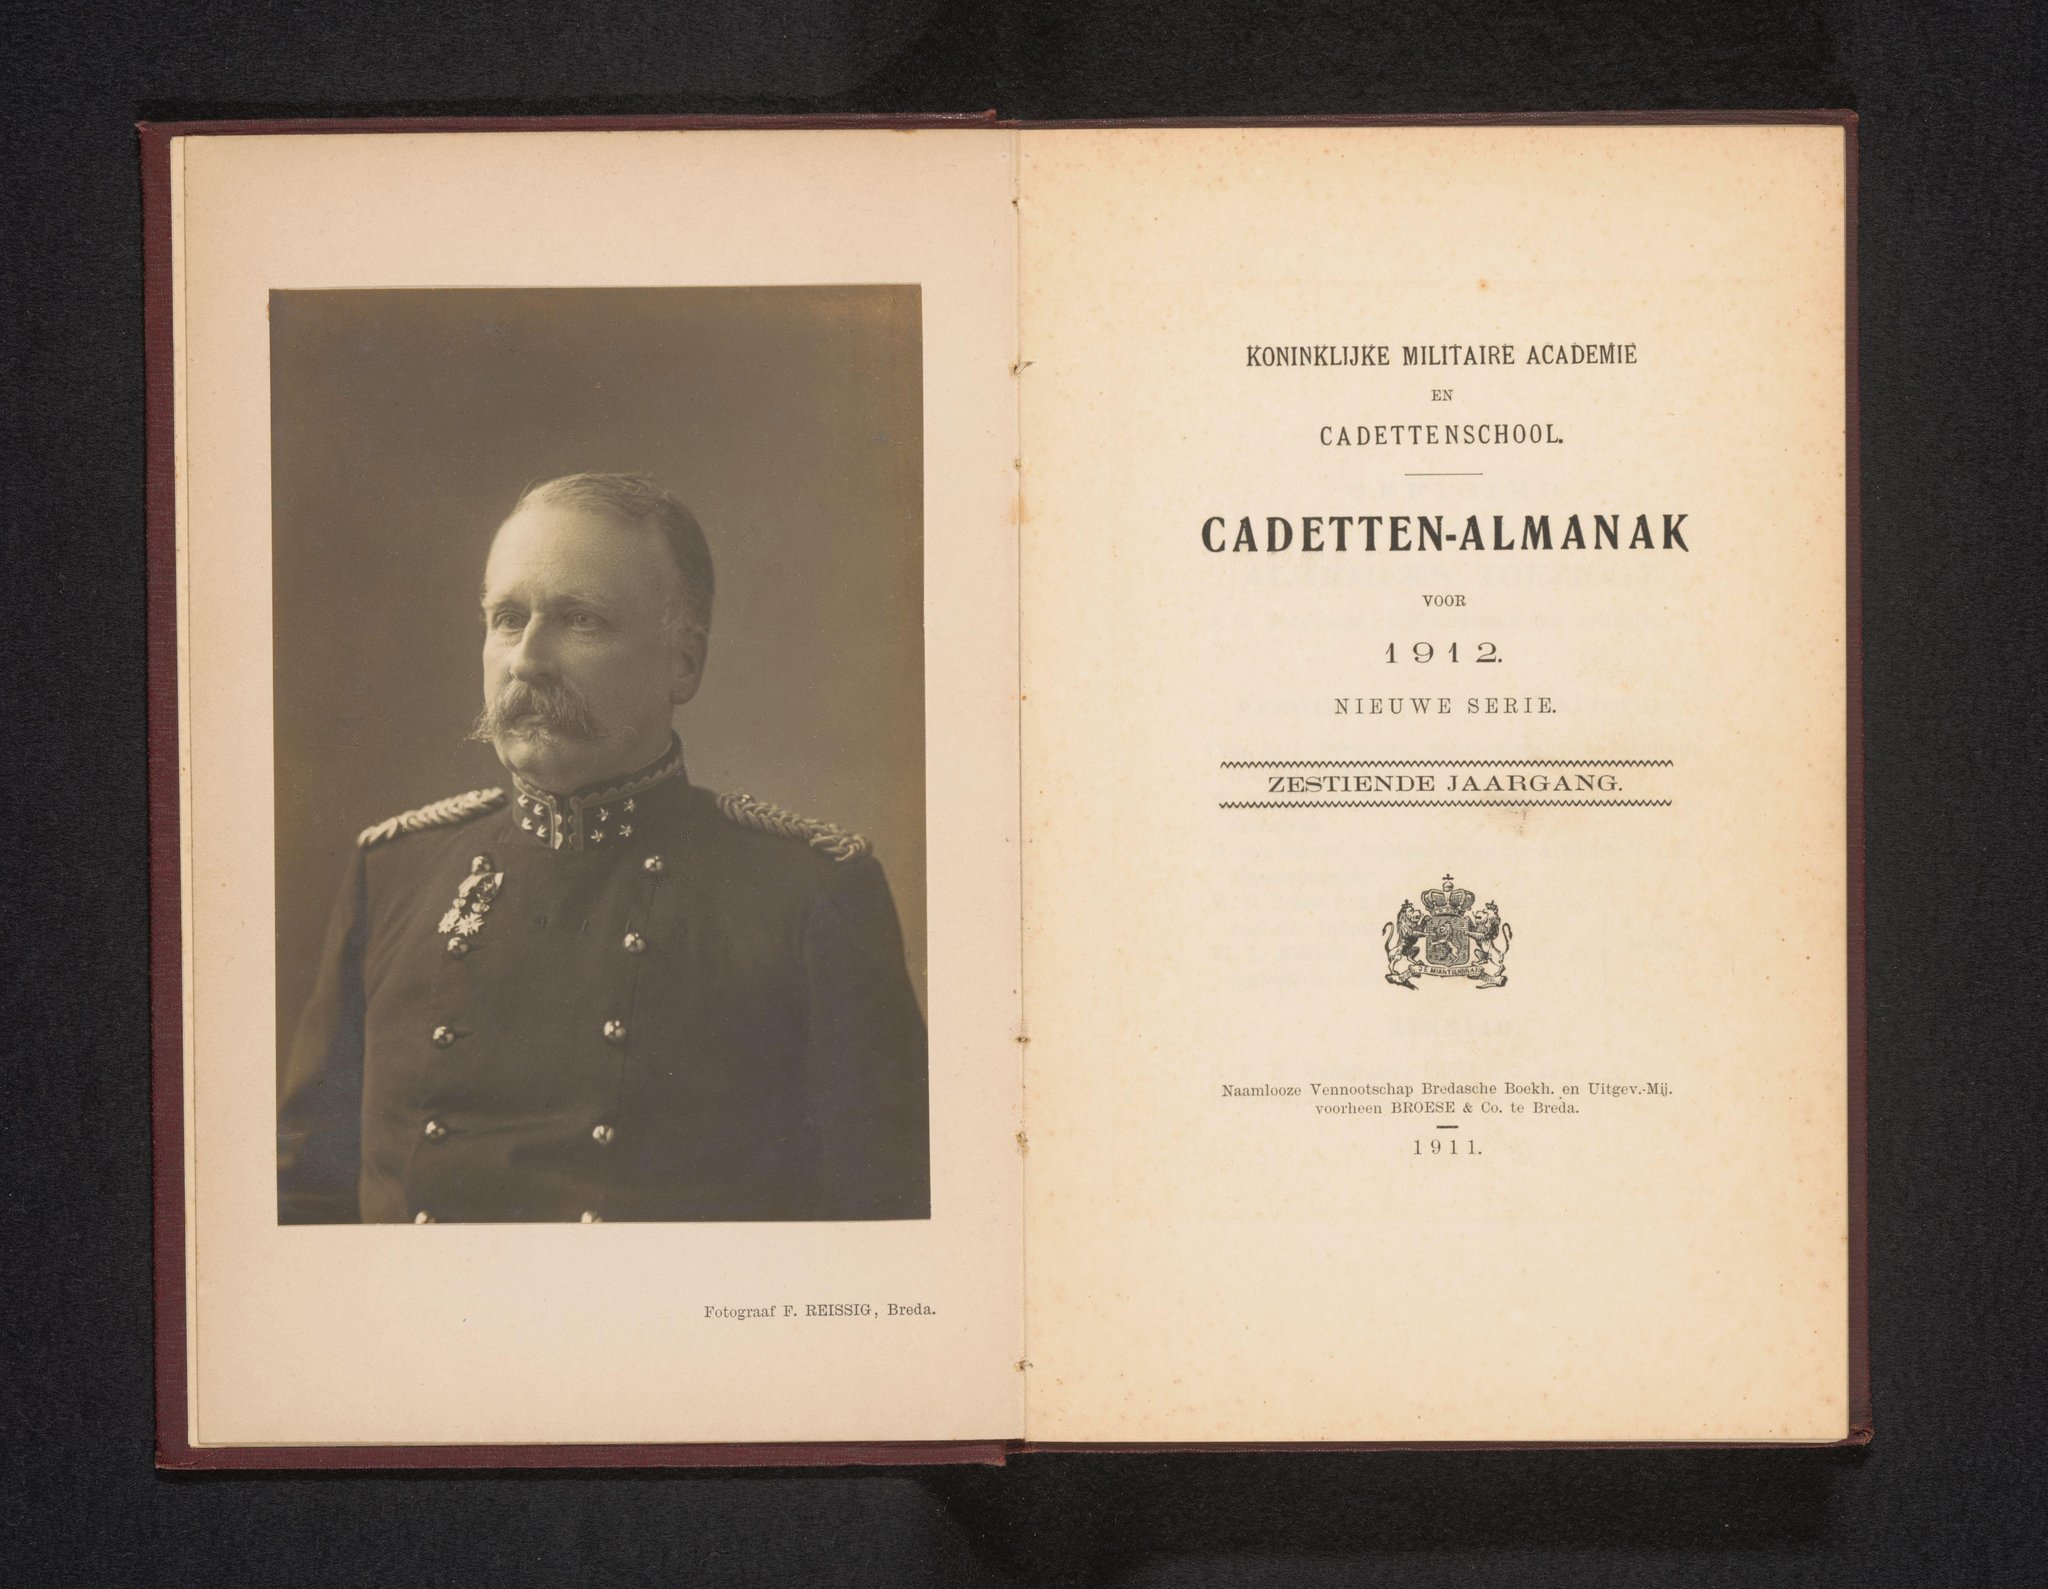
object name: book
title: Cadetten-almanak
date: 1911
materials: cardboard, linen, paper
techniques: decorated paper, gelatin silver print, printing, engraving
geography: breda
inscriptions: name: ‘[...]’